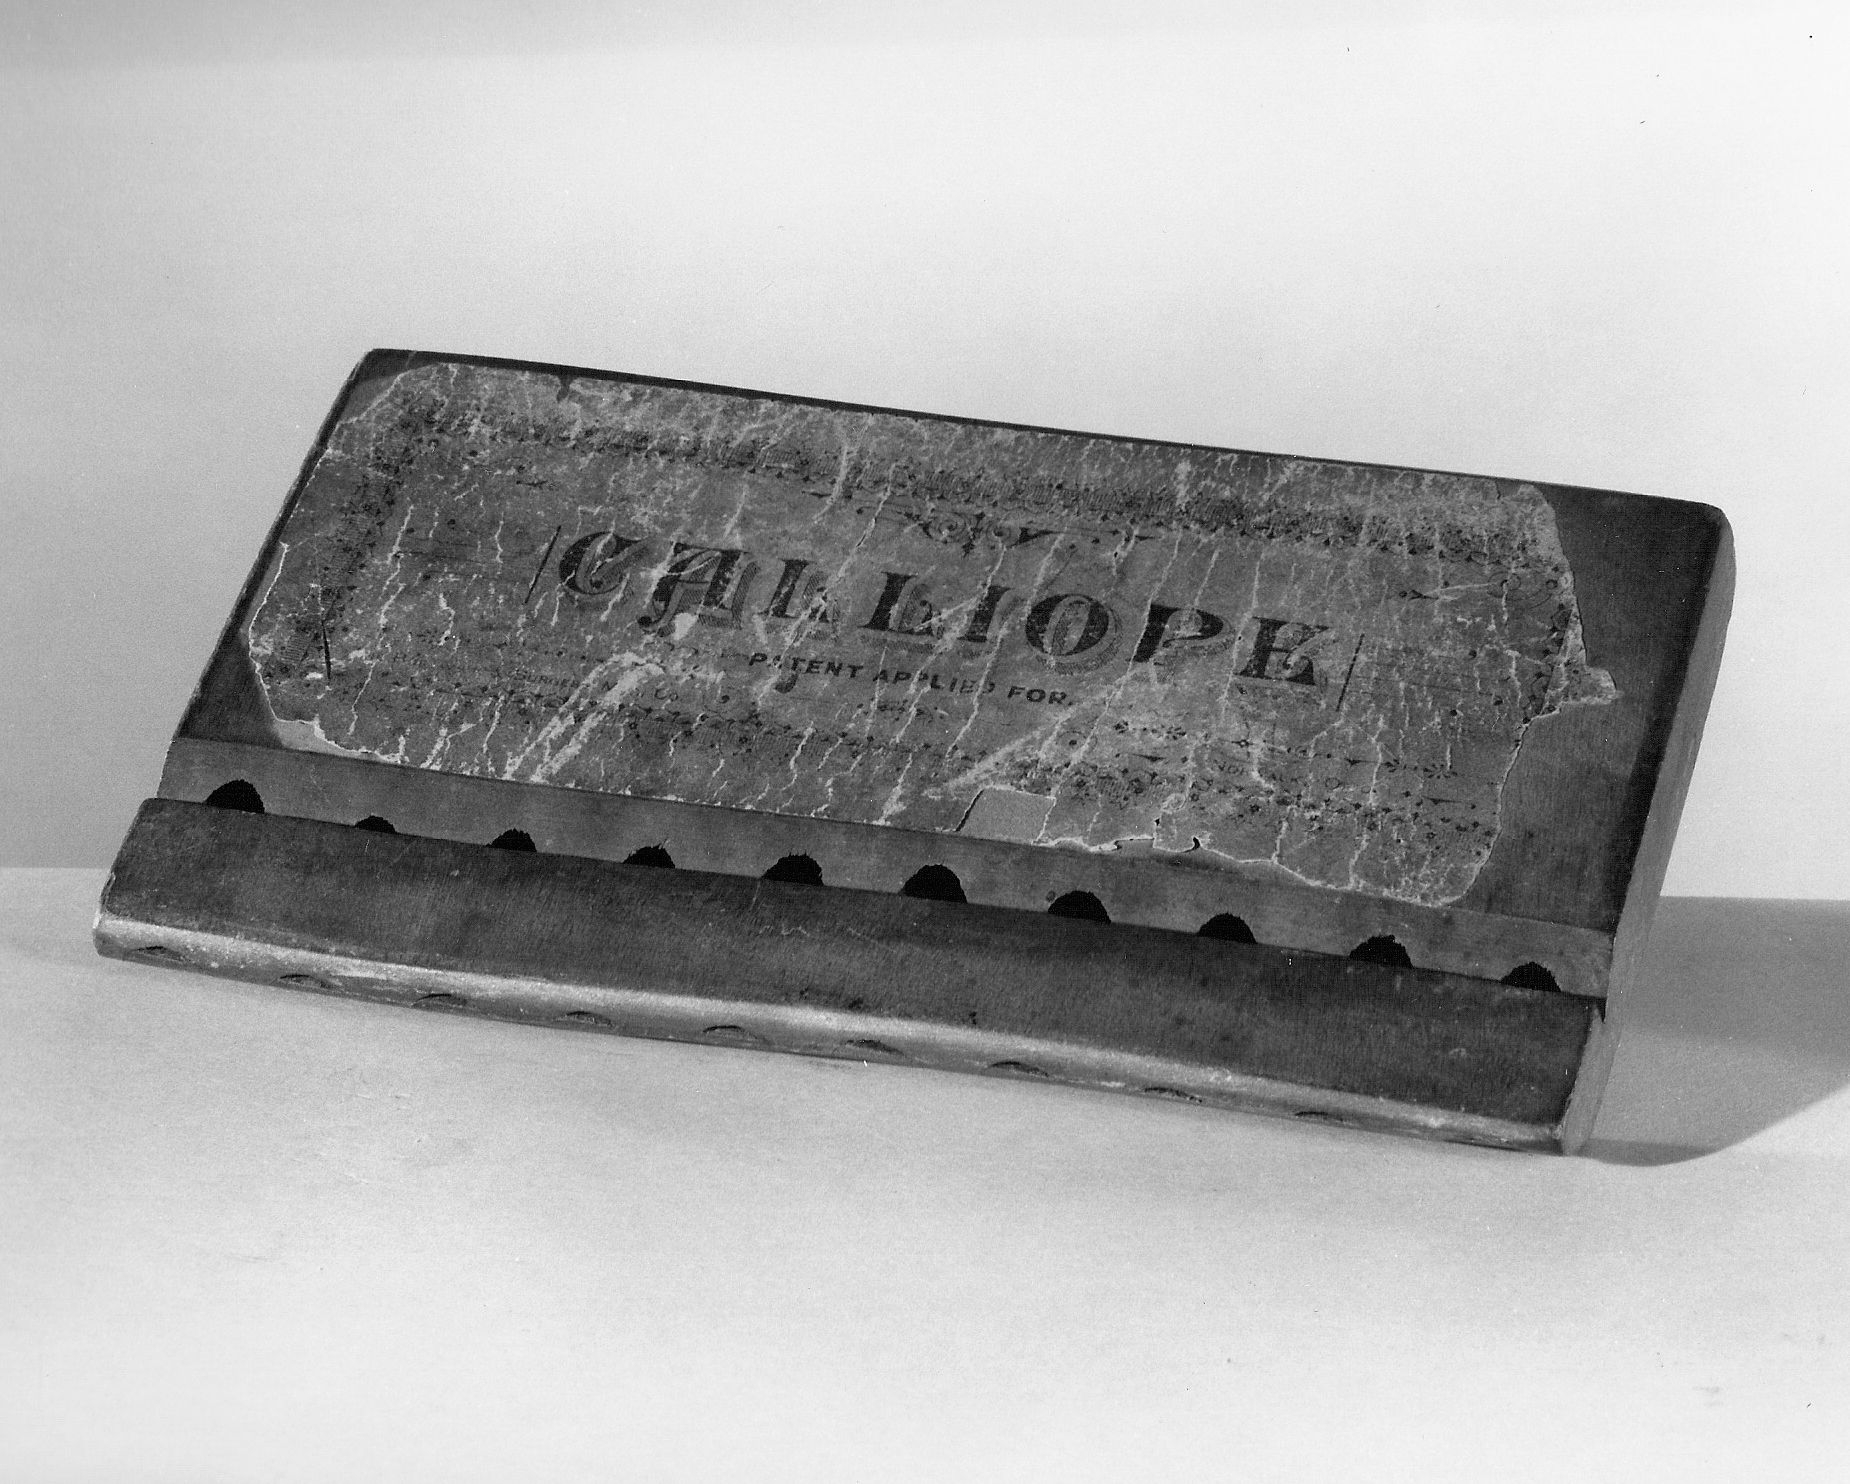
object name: panpipe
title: Panpipes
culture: american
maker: bostwick & burgess manufacturing company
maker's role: maker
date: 1889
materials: wood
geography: united states